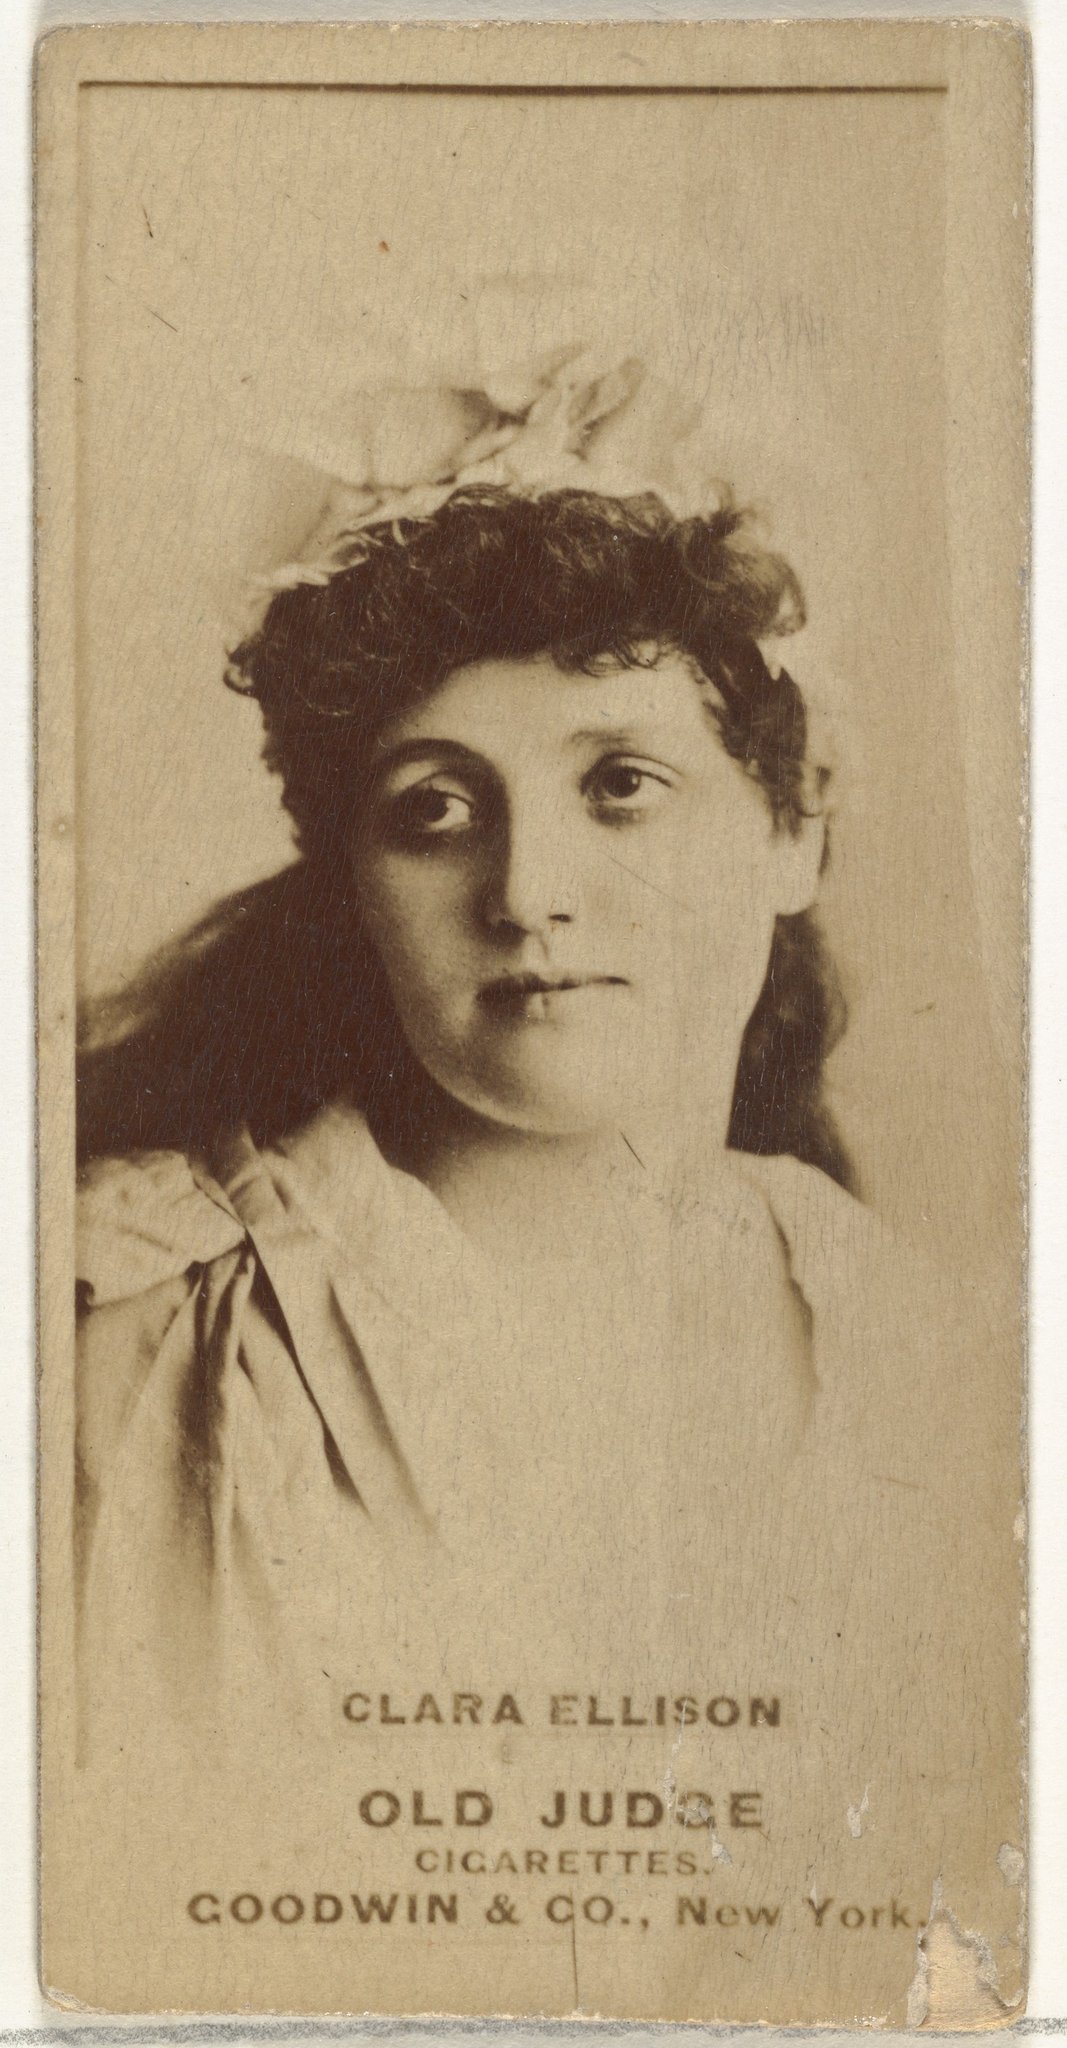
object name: photograph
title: Clara Ellison, from the Actors and Actresses series (N171) for Old Judge Cigarettes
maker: goodwin & company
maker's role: publisher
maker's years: 1850-1950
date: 1886-1890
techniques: albumen silver print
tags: portraits,women,actresses